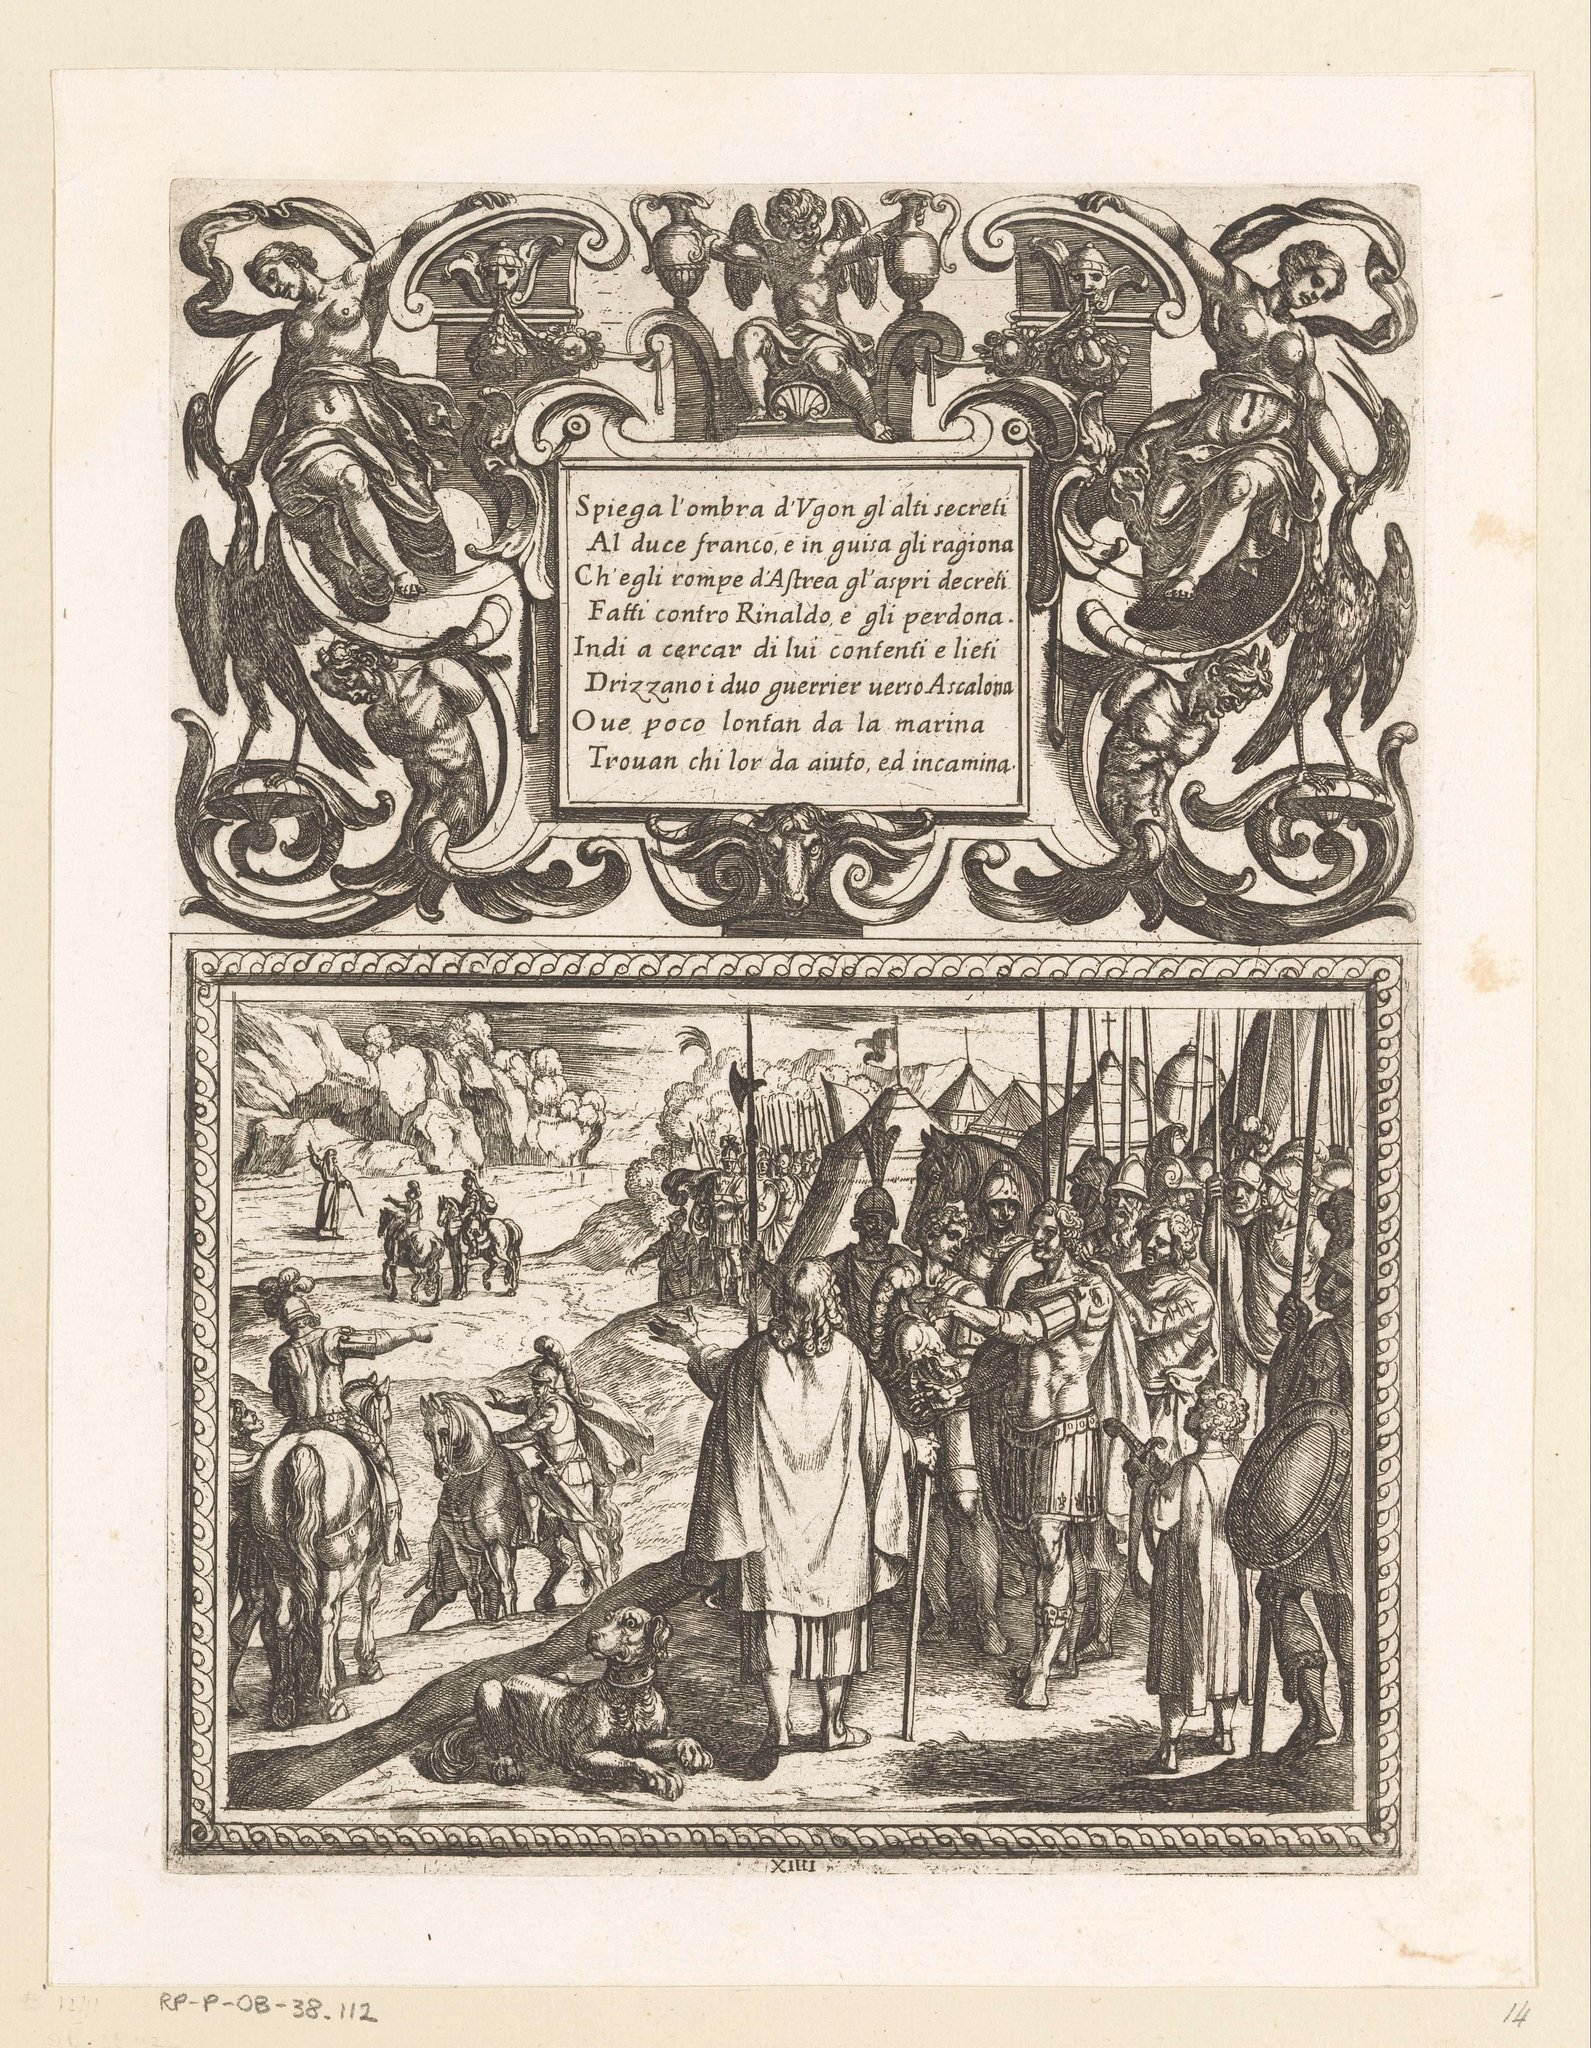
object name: print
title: Gerusalemme Liberata (deel 3)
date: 1565-1630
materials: paper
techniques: etching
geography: italy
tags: ornaments ~ art, sorcerer, magician, wizard, warlock, militant proselytizing: religious war, crusade, etc., ornament ~ cartouche, (scenes from) specific works of literature: tasso, gerusalemme liberata, knight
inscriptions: collector's mark: Lugt 240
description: Deze prent maakt deel uit van een reeks van twintig prenten met ornamentele sierlijsten met daarin voorstellingen van scènes uit Tasso's 'Jeruzalem verlost', een episch gedicht geschreven door de Italiaanse dichter Torquato Tasso en voor het eerst gepubliceerd in 1581. Het verhaal vertelt grotendeels in fictie over de Eerste Kruistocht waarin de christenen, geleid door Godfried van Bouillon, de strijd aangaan met de moslims om het Beleg van Jeruzalem.